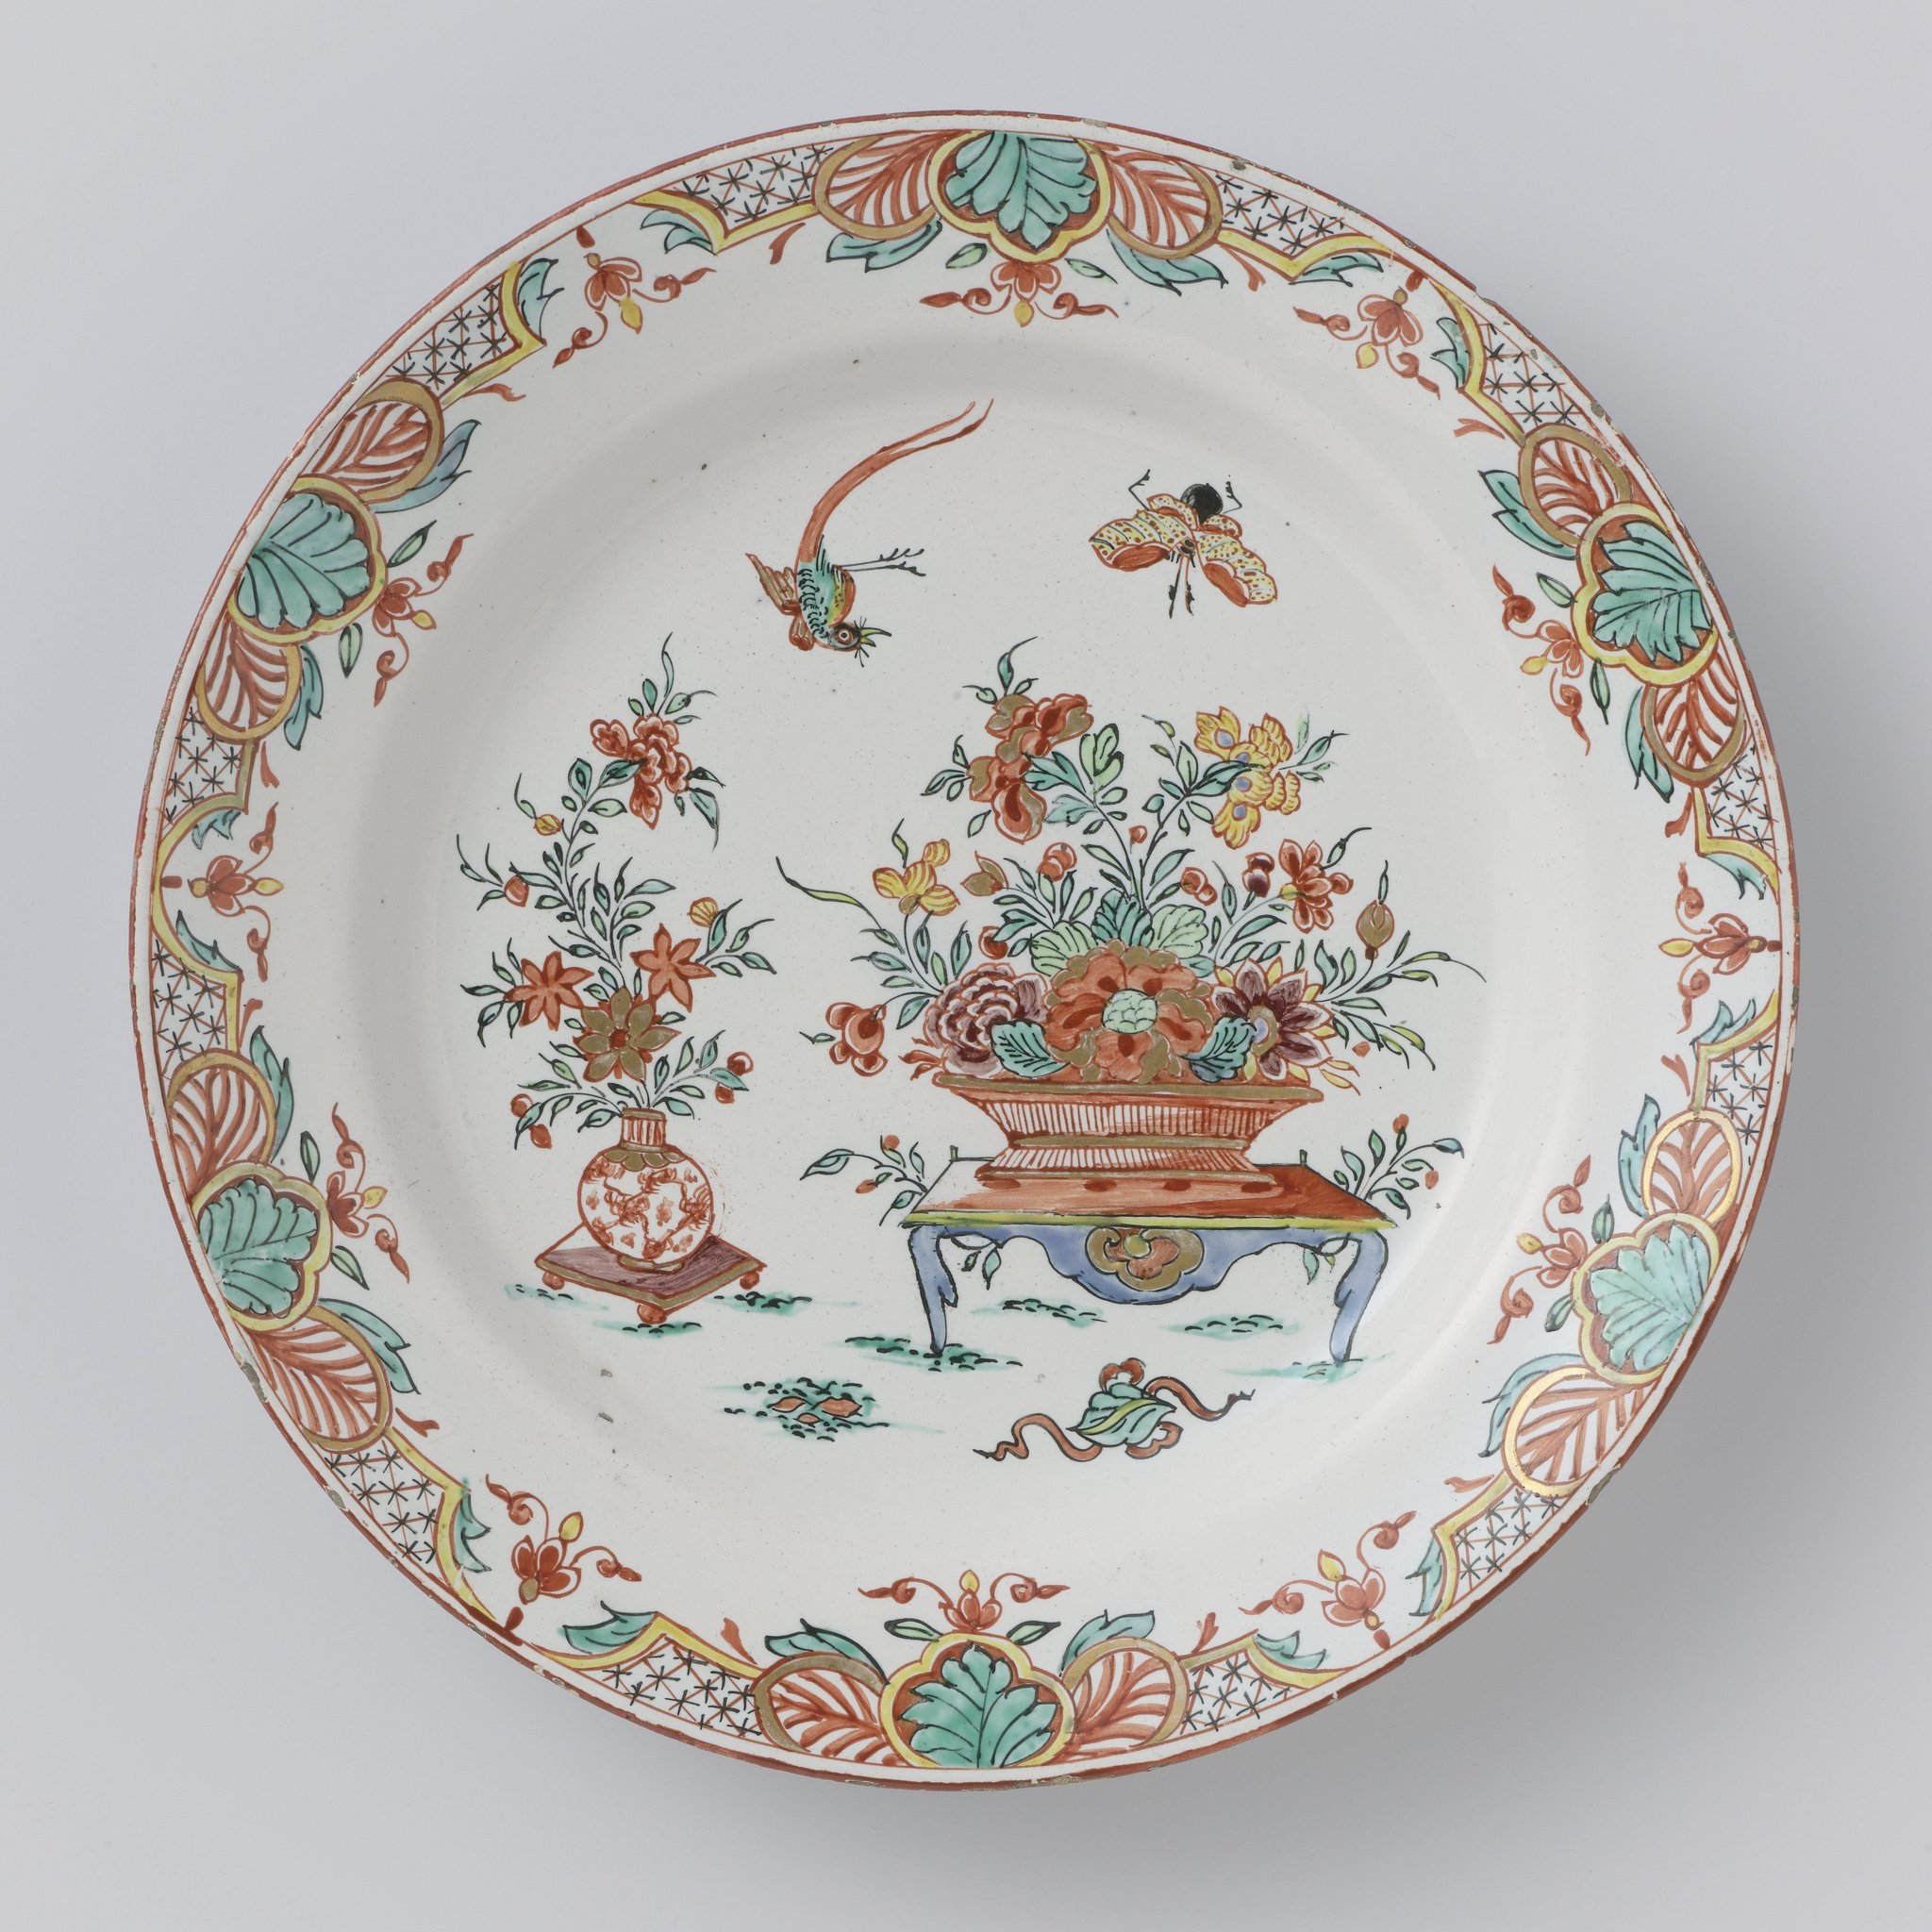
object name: plate dish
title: Bord van veelkleurig beschilderde faïence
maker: Anonymous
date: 1750-1770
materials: faience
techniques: kiln, painted, polychromy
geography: delft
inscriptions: collector's mark: ‘collection J.F. Loudon’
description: Plate. Faience. Delft, c. 1750 - 1770. Given by the heirs of John F. Loudon, 1916.